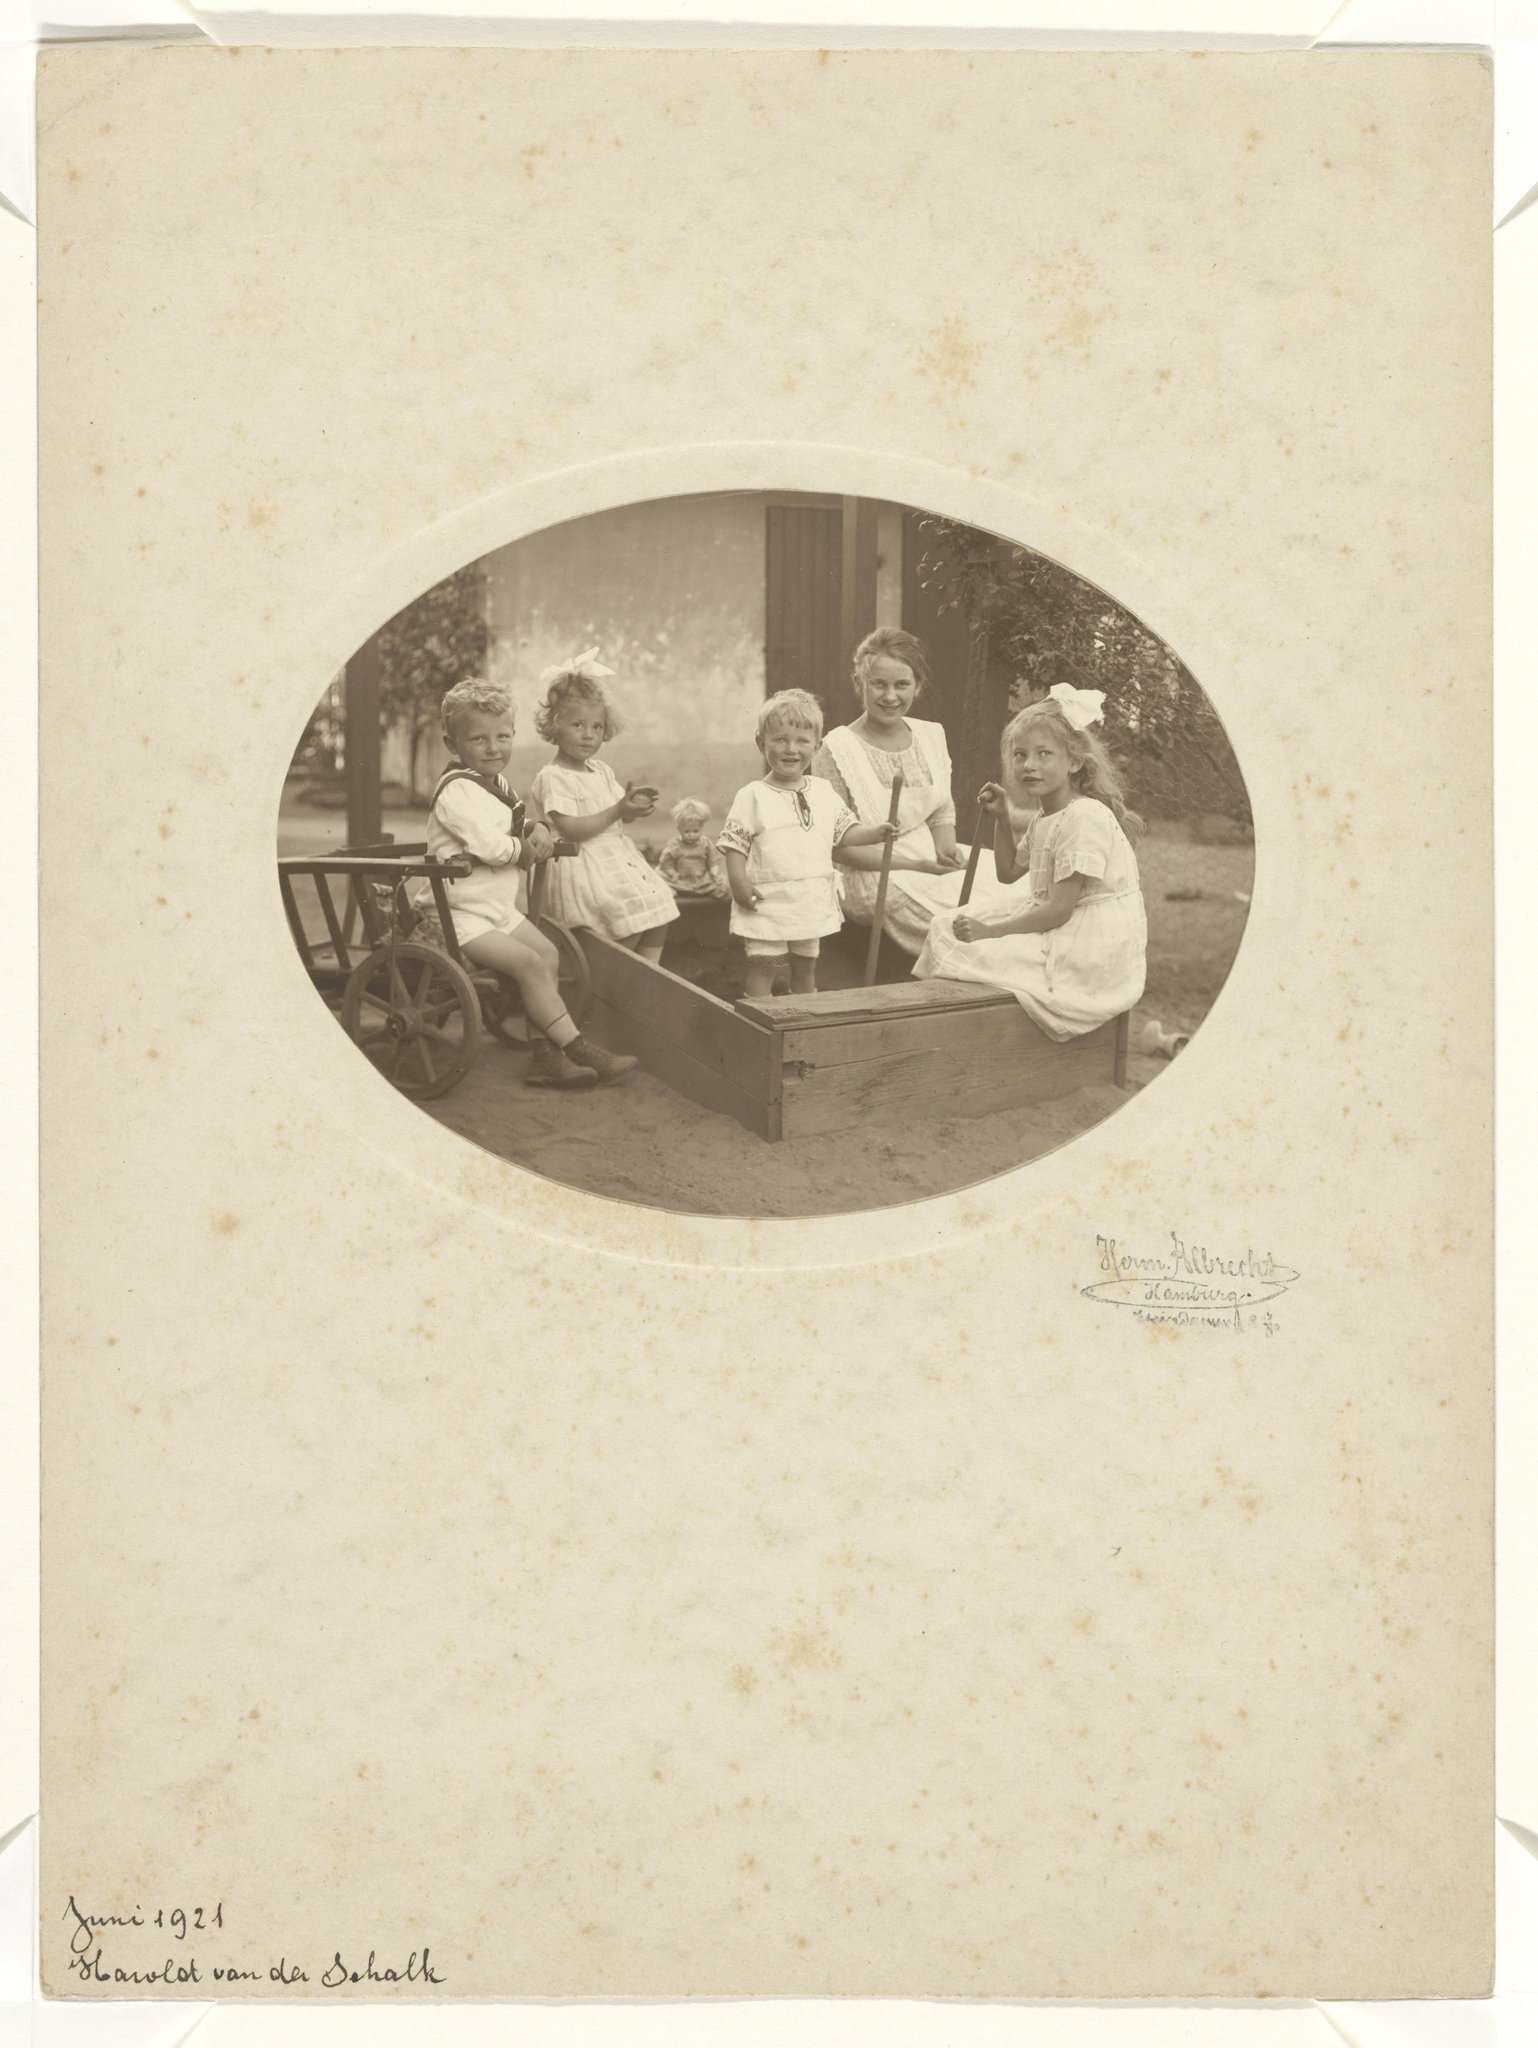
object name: photograph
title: Groepsportret van een onbekende jonge vrouw met vier kinderen in een zandbak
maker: hermann albrecht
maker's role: fotograaf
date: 1906-1921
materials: paper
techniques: gelatin silver print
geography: hamburg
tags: (playing with) building play-material, ensemble of pieces of clothing: sailor suit, child, anonymous historical person portrayed, maid ~ house personnel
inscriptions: stamp: ‘Herm. Albrecht/ Hamburg./ Steindamm 8.’, inscription: ‘Juni 1921/ Harvlot van der Schalk’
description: Vier kinderen met speelgoed, in en naast een zandbak, met een kindermeisje.